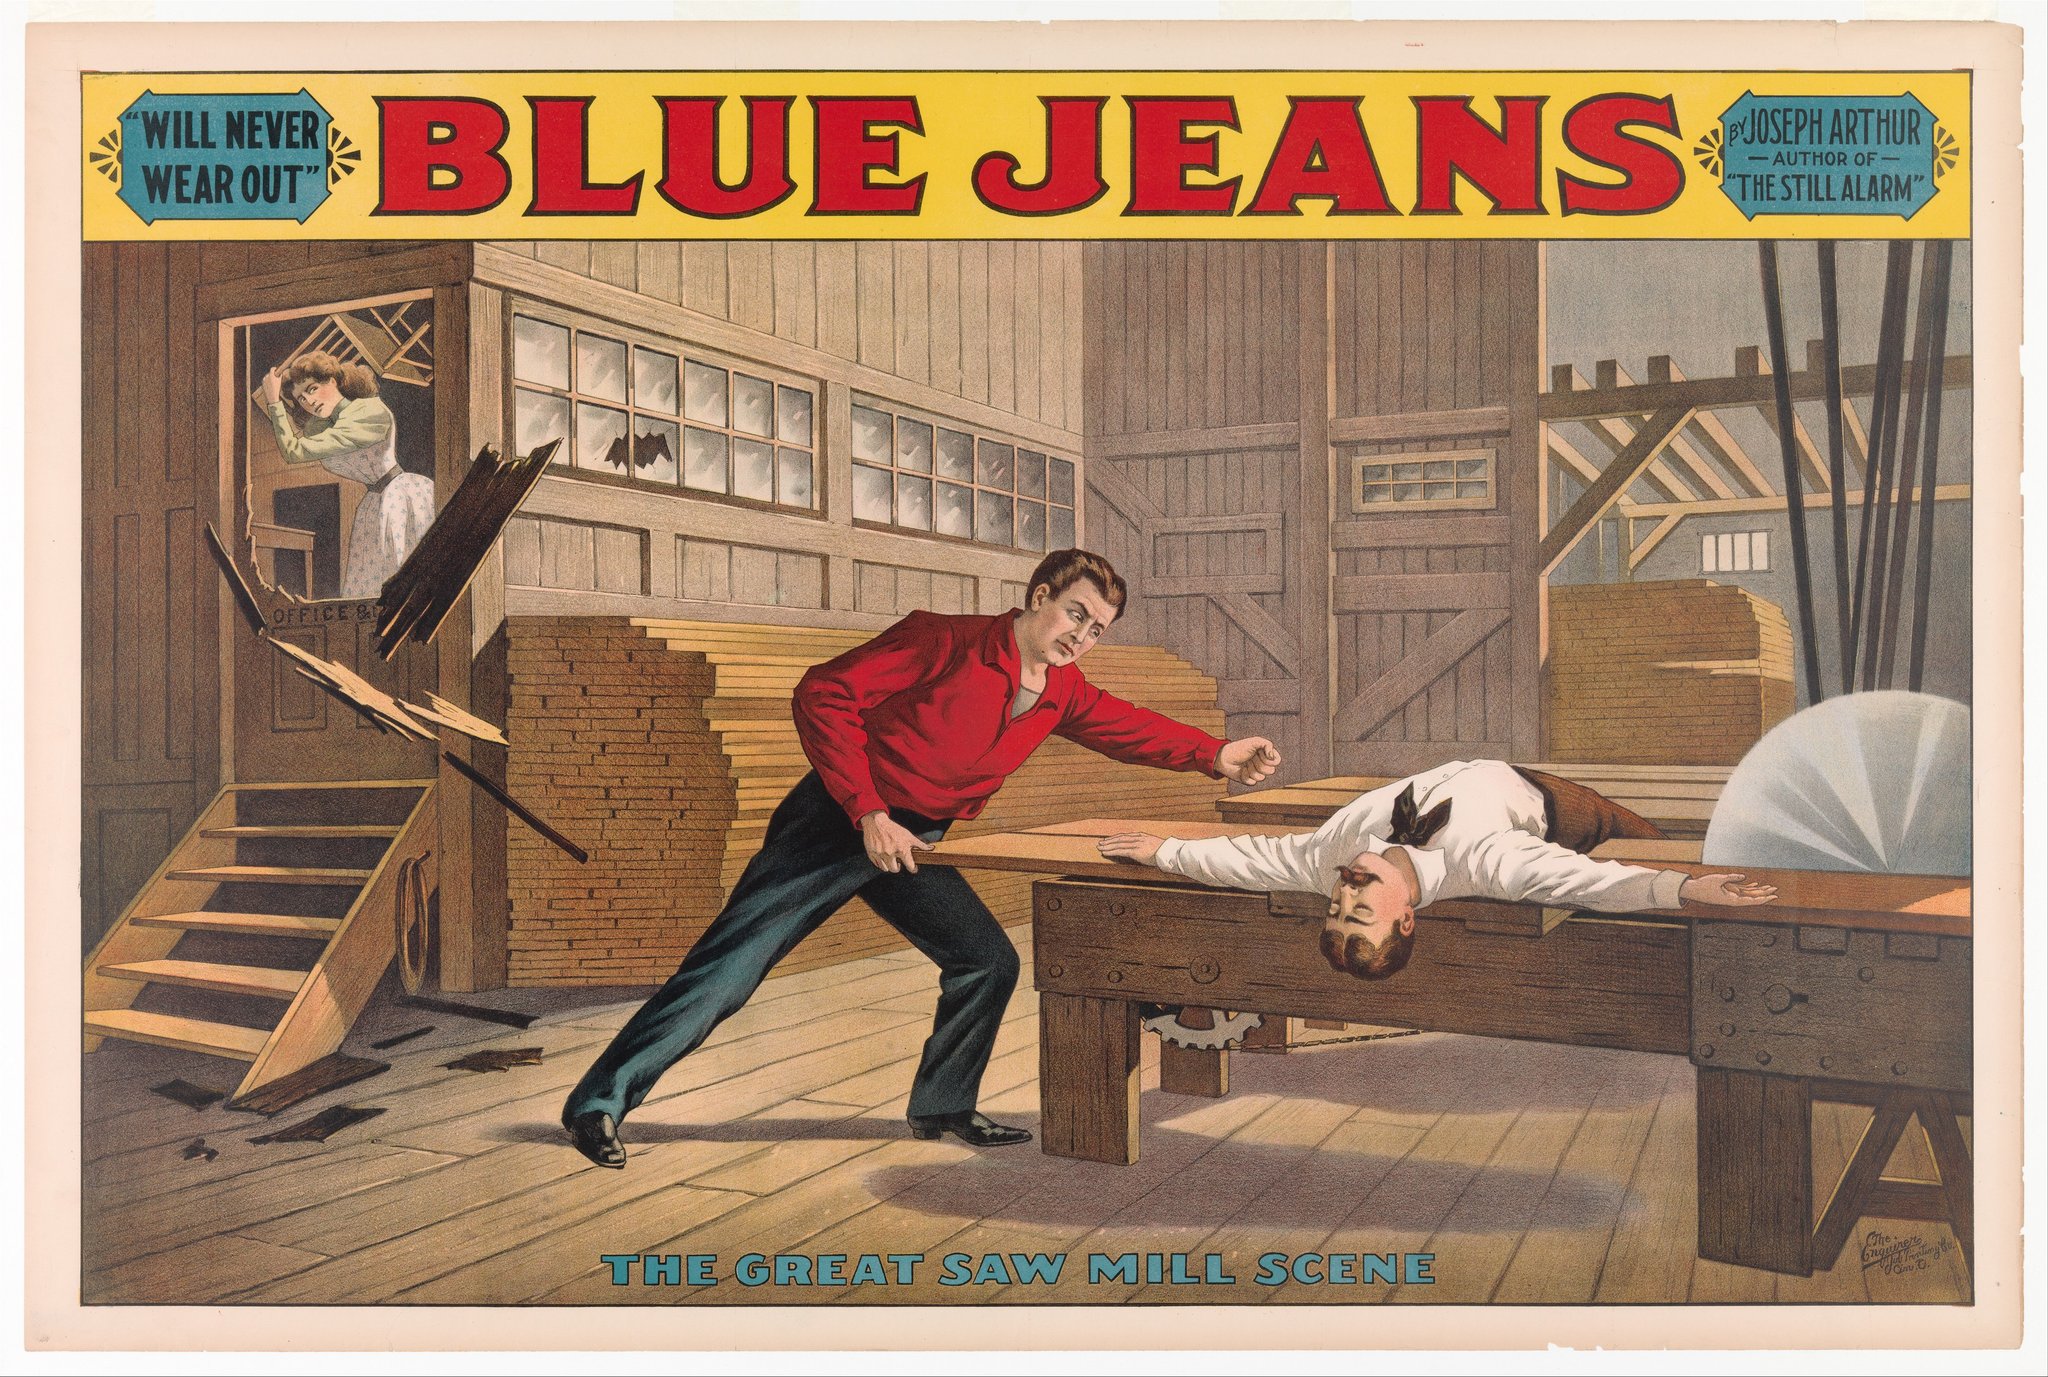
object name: print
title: Saw Mill Scene, from Blue Jeans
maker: anonymous, american, 19th century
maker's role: artist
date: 1890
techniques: lithograph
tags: men